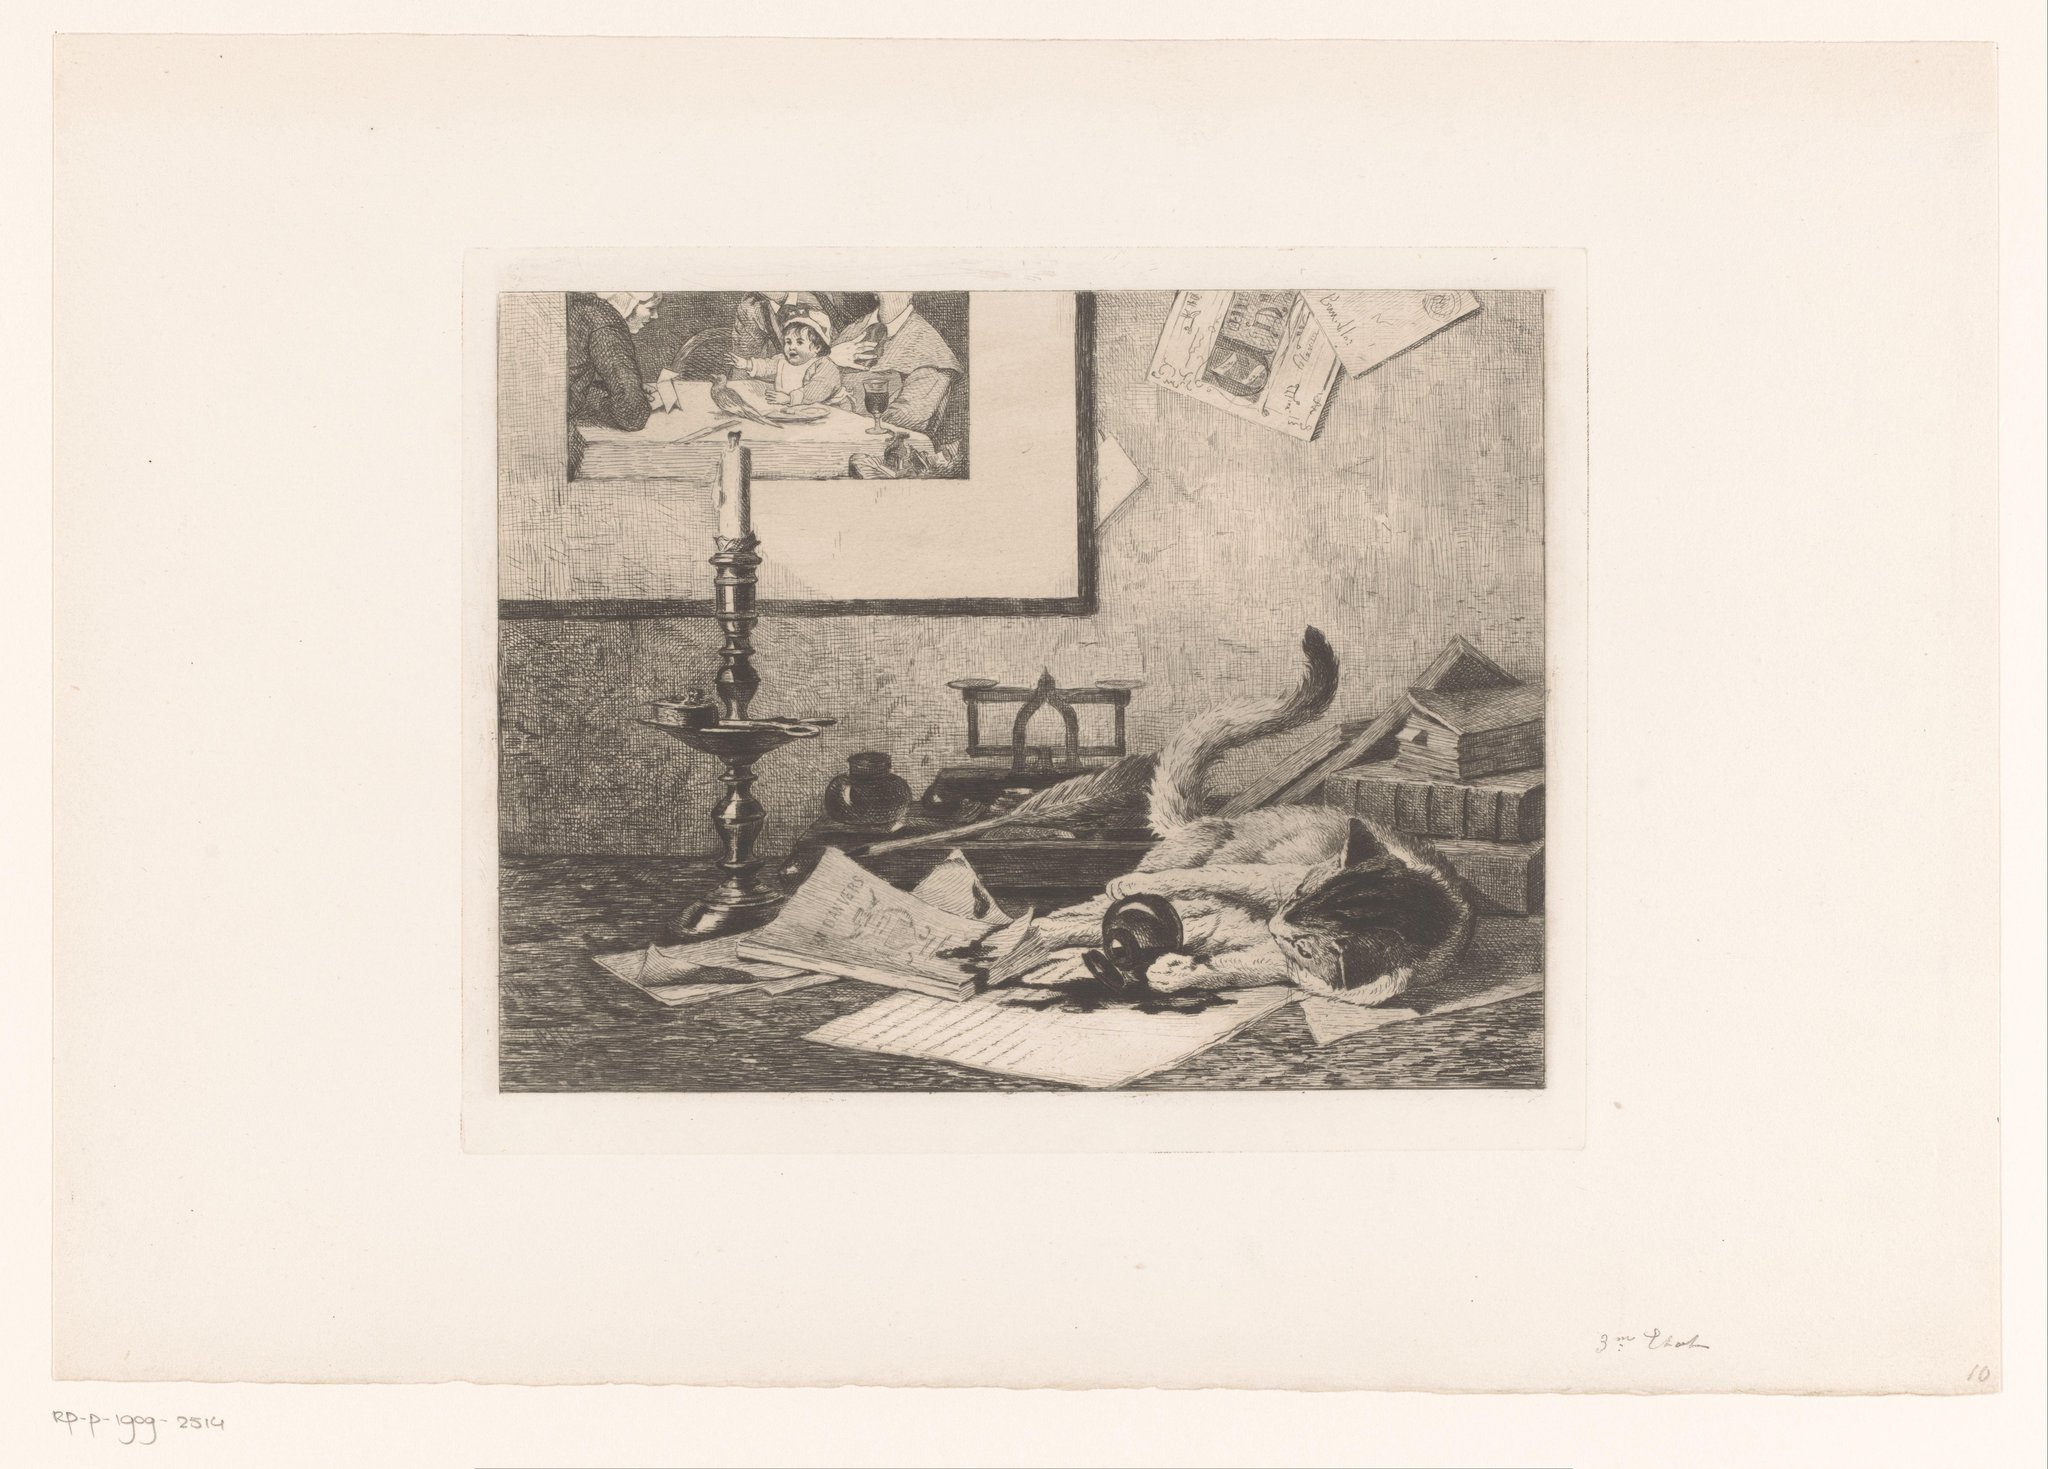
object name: print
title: Spelende kat knoeit een inktpot over tafel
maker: eduard van den bosch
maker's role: print maker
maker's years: 1828-1878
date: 1870-1880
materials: paper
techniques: drypoint, etching, intaglio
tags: cat, ink-well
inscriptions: collector's mark: Lugt 2228, annotation: ‘3me Etat’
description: Een latere staat van deze prent is gebruikt in een van de afleveringen van: Album du Journal des Beaux-Arts. Antwerpen: s.n., 1870-1880.